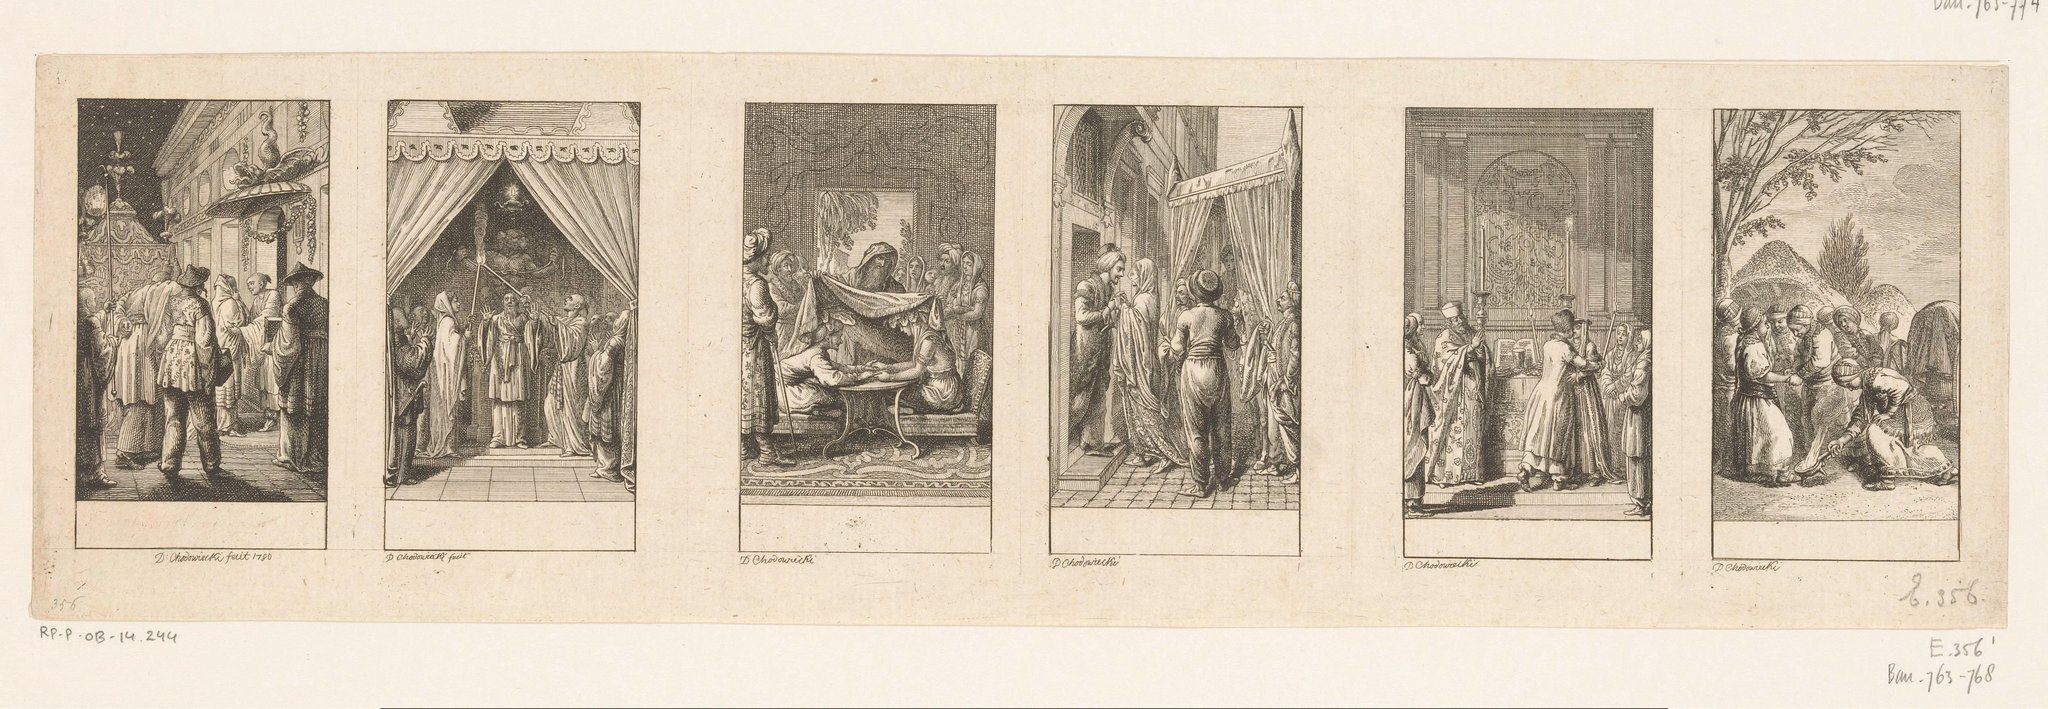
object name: print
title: Zes voorstellingen met huwelijksgebruiken bij verschillende volkeren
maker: daniel nikolaus chodowiecki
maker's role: draughtsman, print maker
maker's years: 1726-1801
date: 1780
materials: paper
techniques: etching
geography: berlin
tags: hinduism, buddhism, jainism, asiatic races and peoples: turks, chinese, europeans (with name), japanese, (civil) marriage ceremonies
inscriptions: collector's mark: Lugt 2228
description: Van links naar rechts; het Chinese huwelijk, het Japanse huwelijk, het Hindoestaanse huwelijk, het Turkse huwelijk, het Griekse huwelijk en het Mordwiense huwelijk.